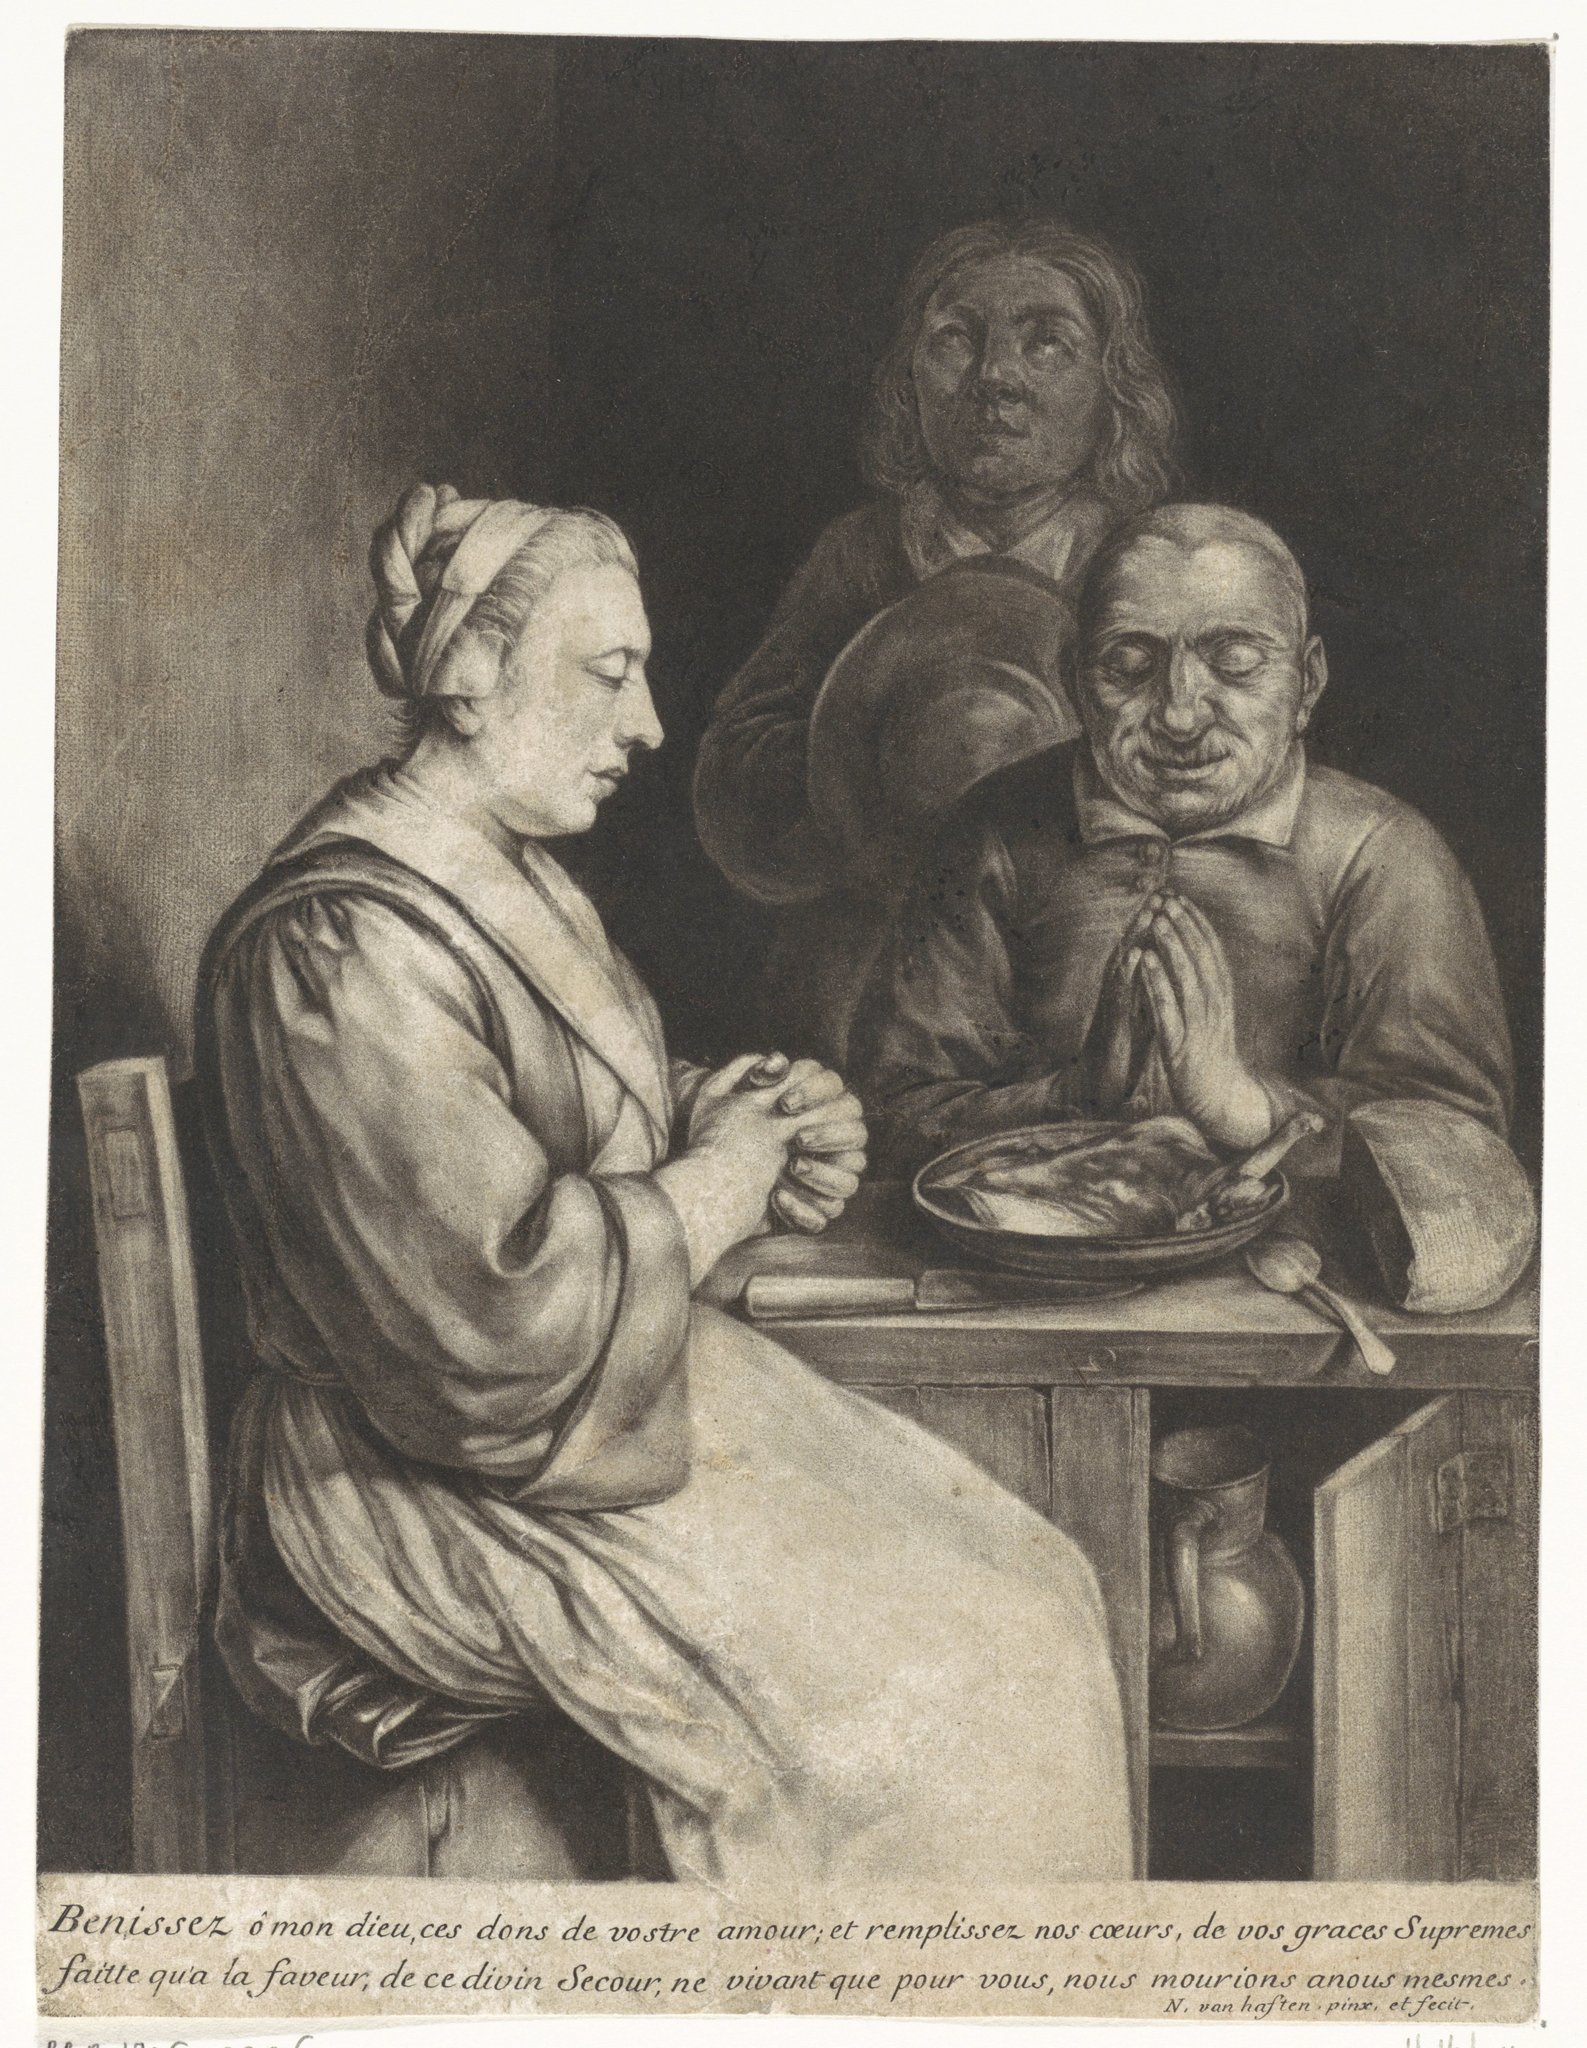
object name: print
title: Gebed voor de maaltijd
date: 1673-1715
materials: paper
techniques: engraving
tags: prayer at table, saying grace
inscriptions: collector's mark: Lugt 2228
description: Twee mannen en een vrouw in gebed voor de maaltijd. Op tafel liggen vlees en brood.